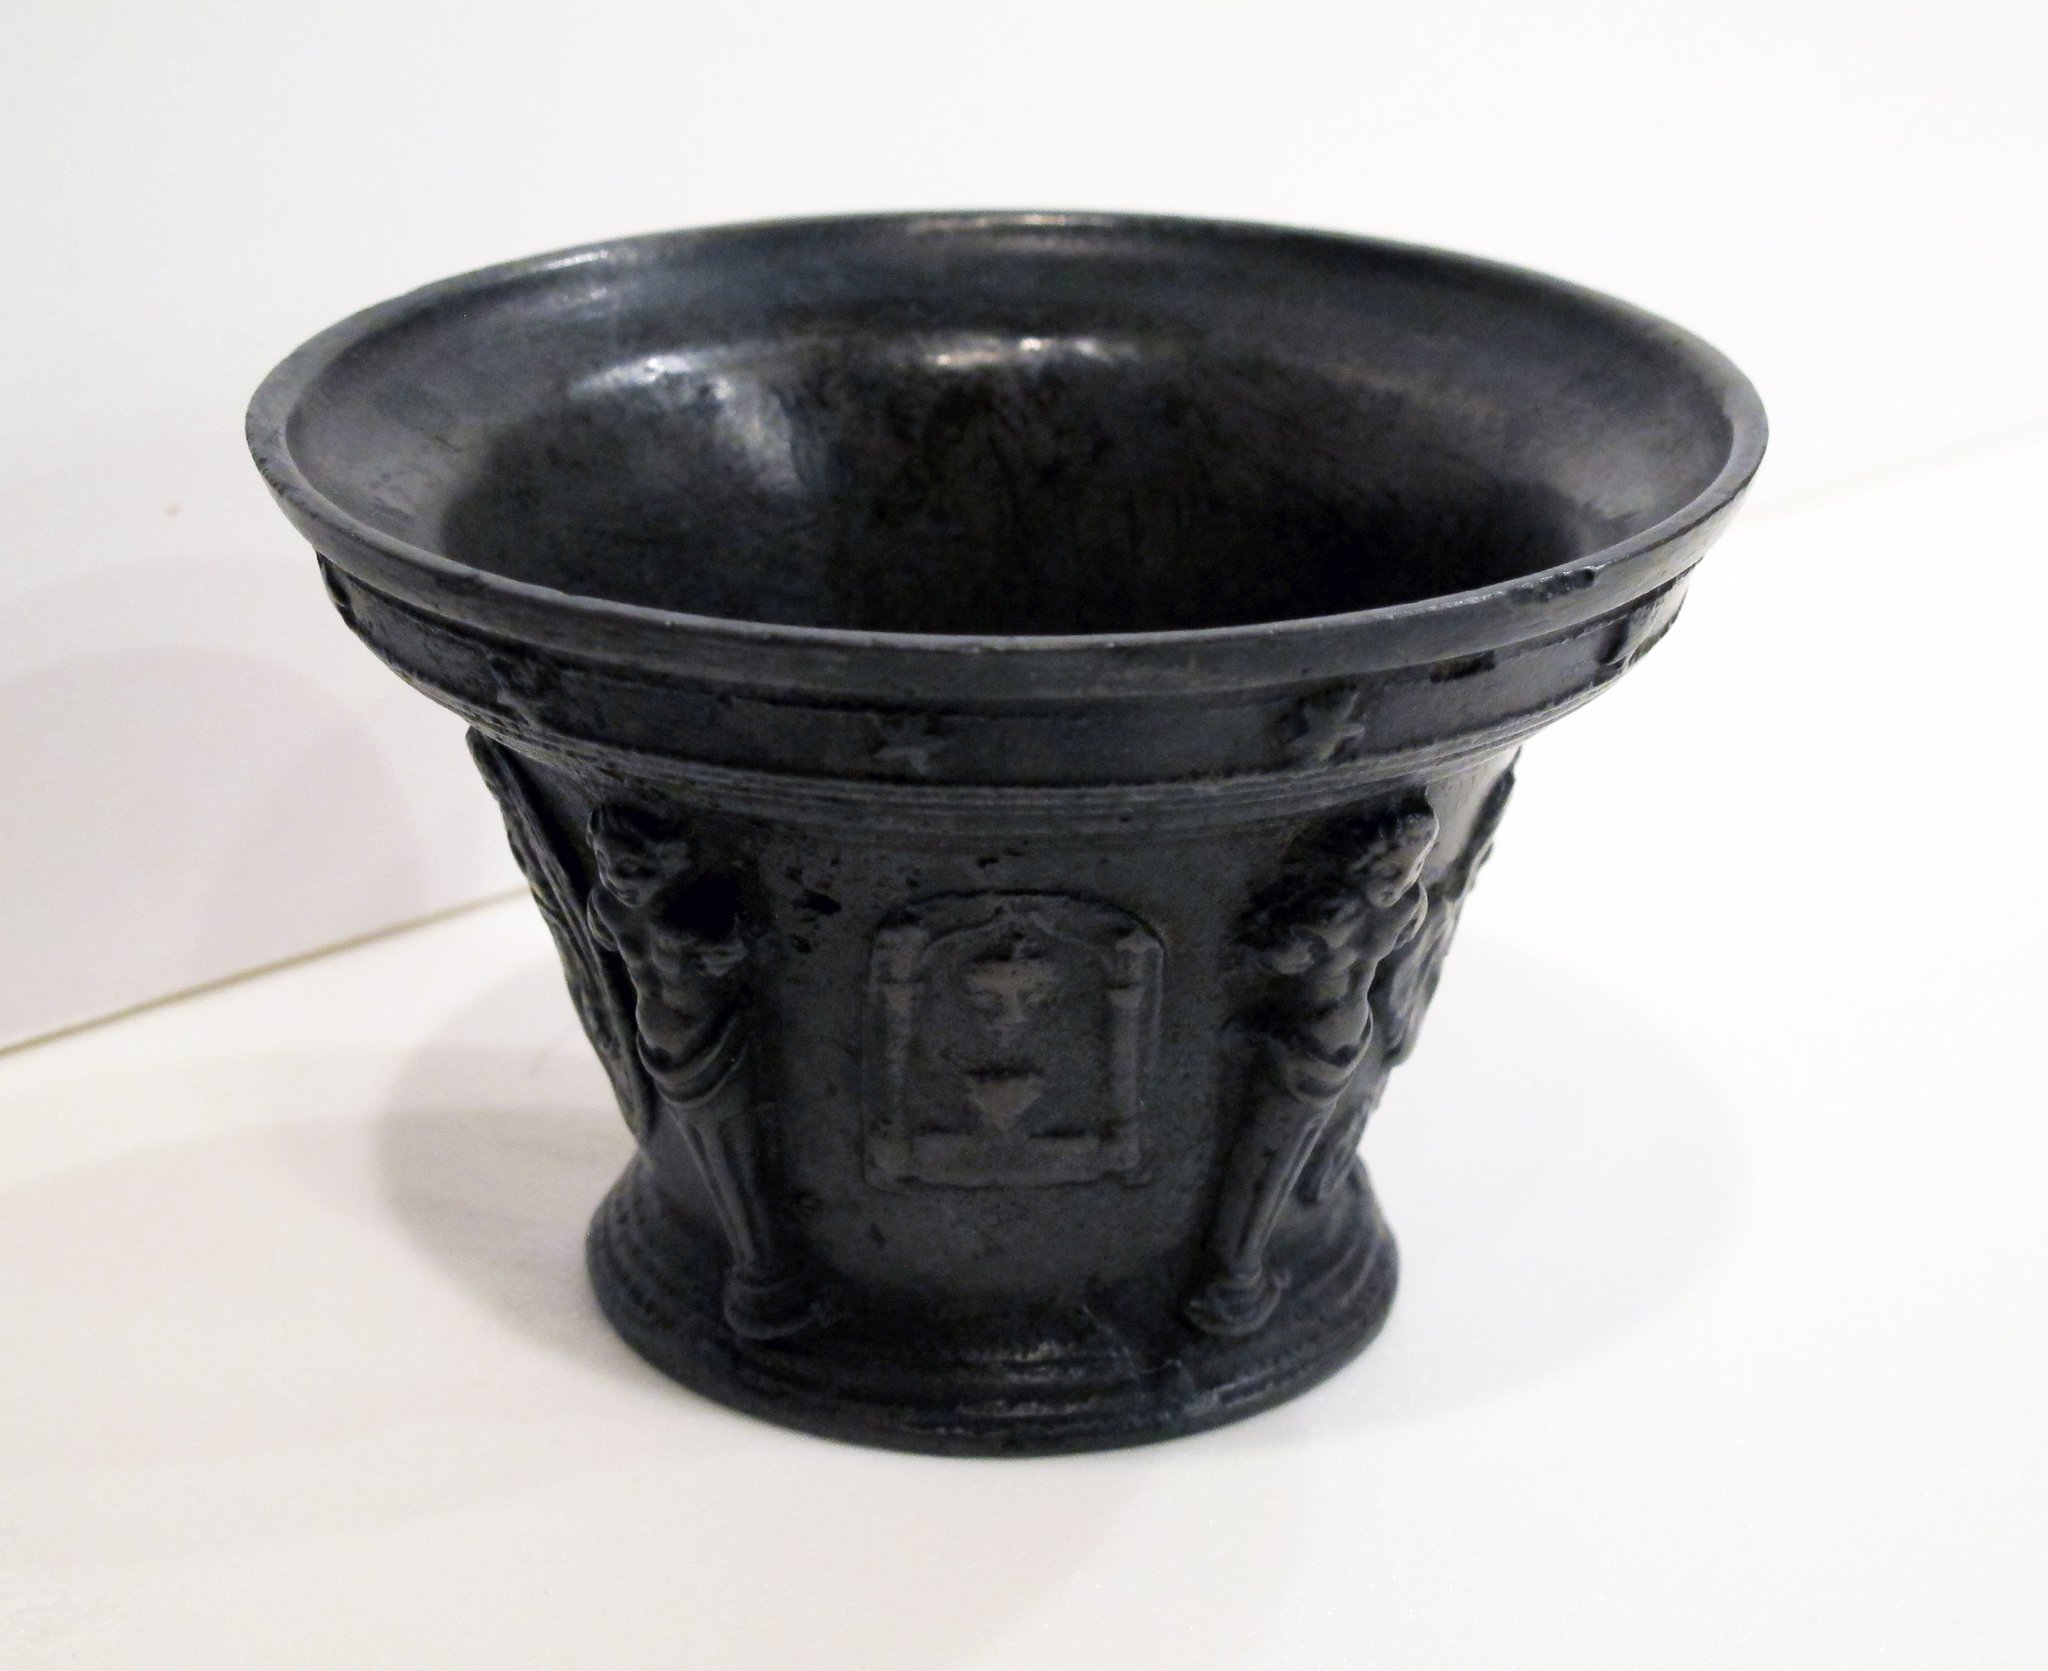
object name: mortar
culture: french or north italian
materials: copper alloy, patina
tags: caryatids